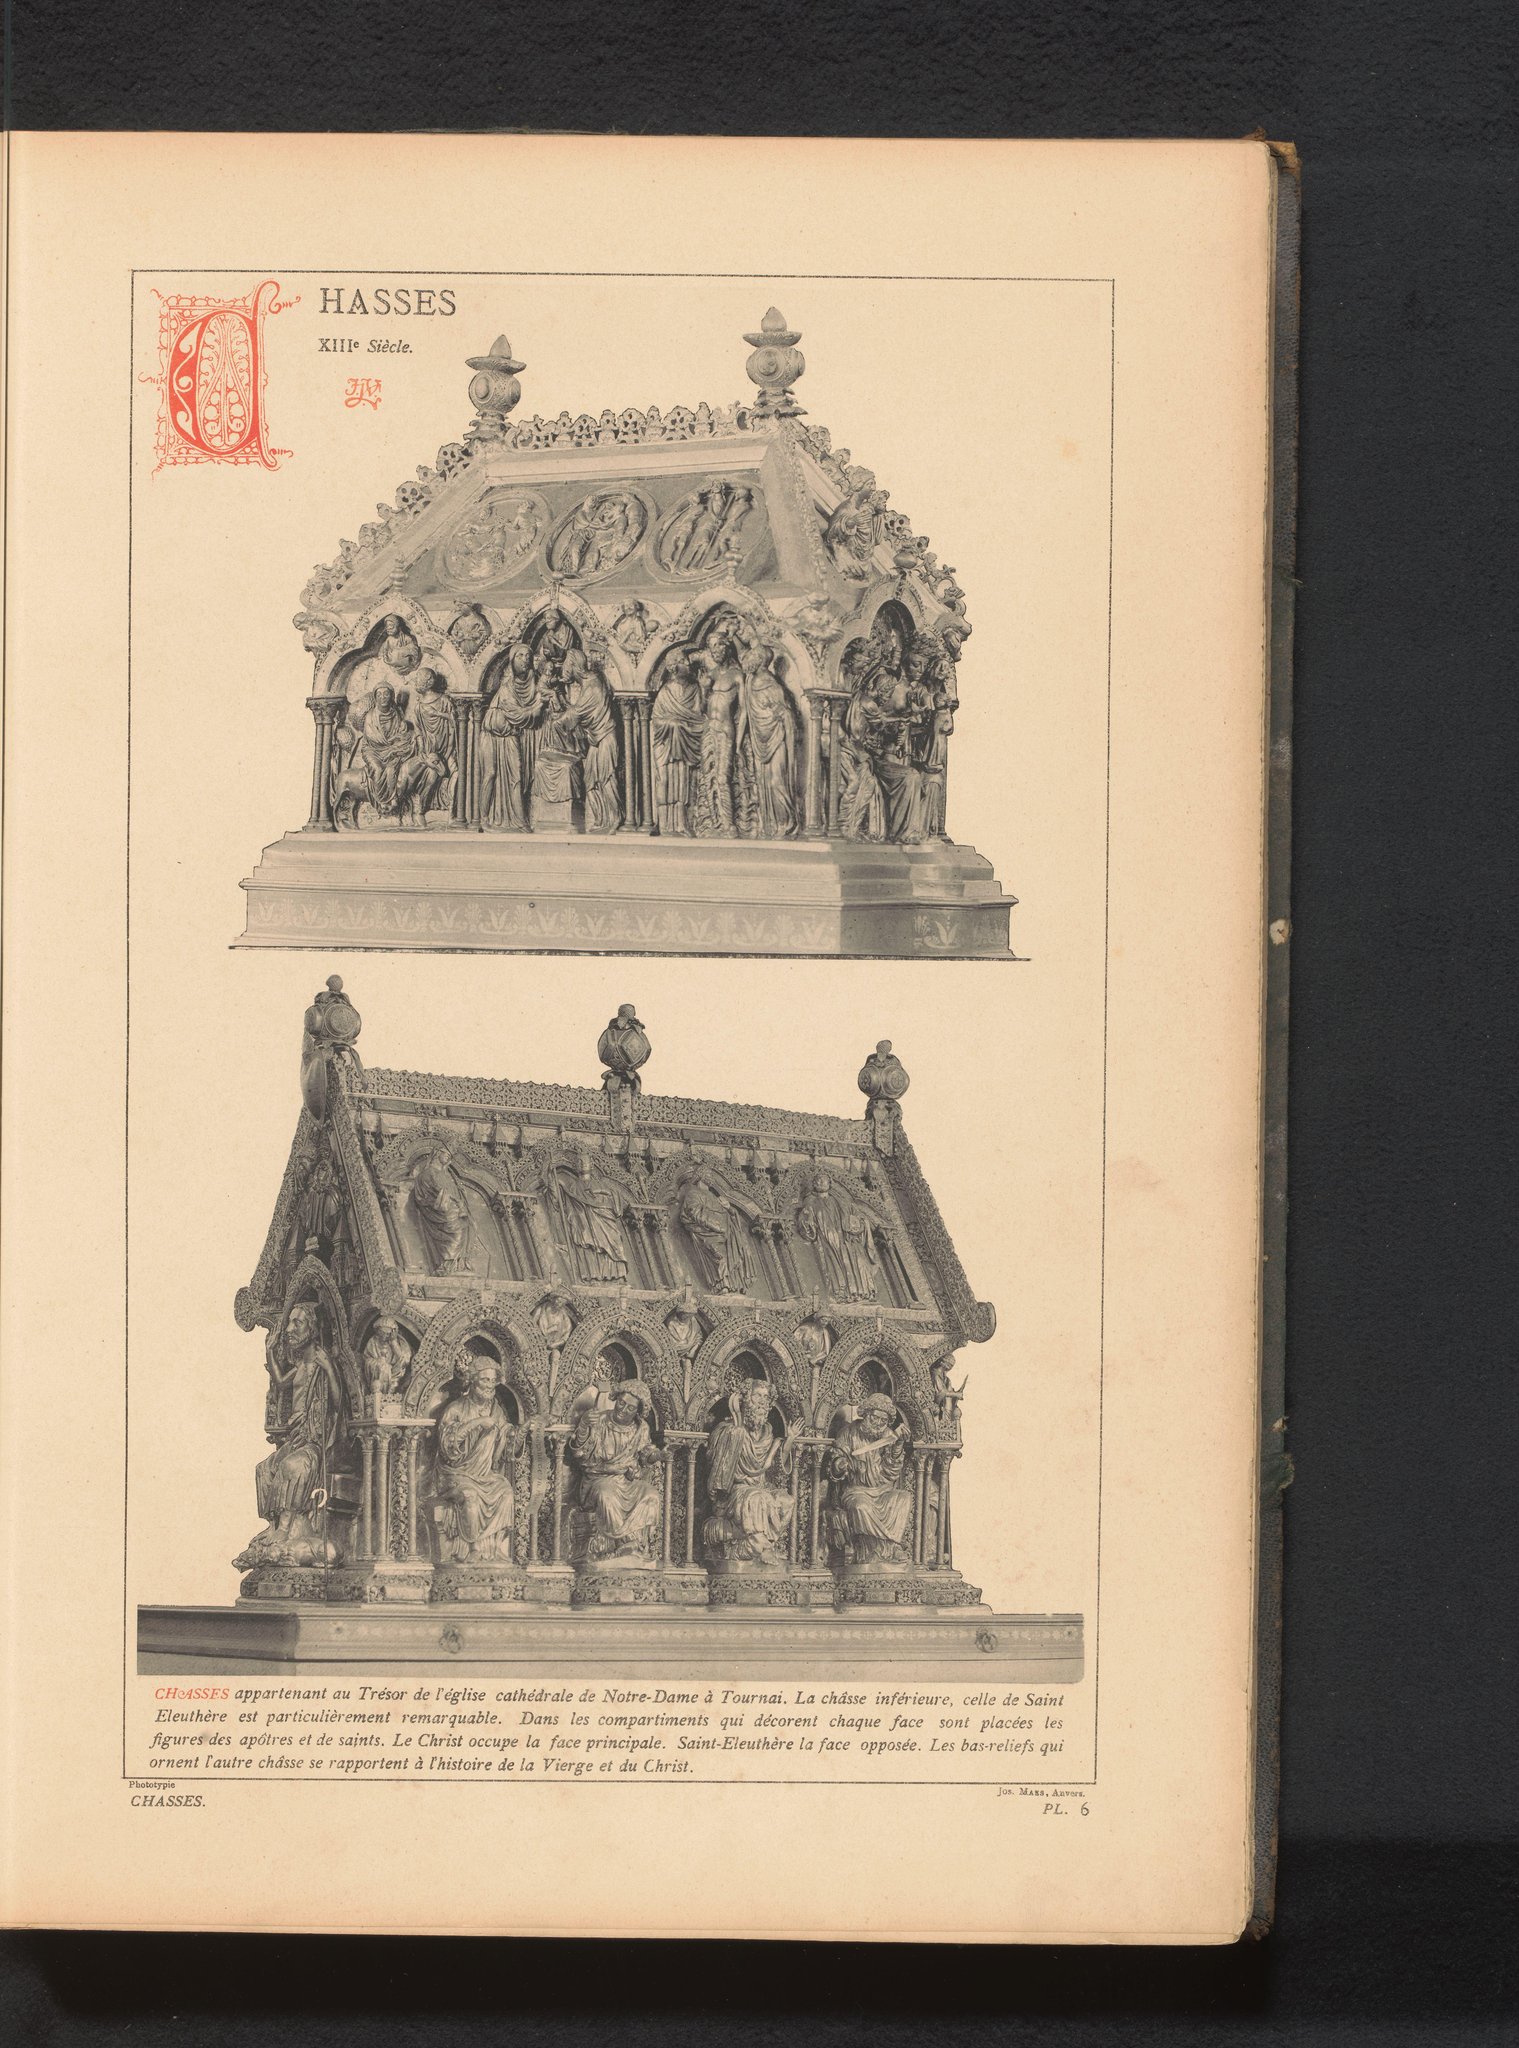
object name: photomechanical print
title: Twee relikwieënkasten van de heilige Eleutherius in de Onze-Lieve-Vrouwekathedraal in Doornik, België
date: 1882-1887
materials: paper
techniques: photograph, photolithography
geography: antwerp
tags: relics (and reliquaries)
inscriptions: inscription: ‘CHASSE appartenant au (...)’, monogram: ‘JJvY’, inscription: ‘CHASSES. - PL. 6’